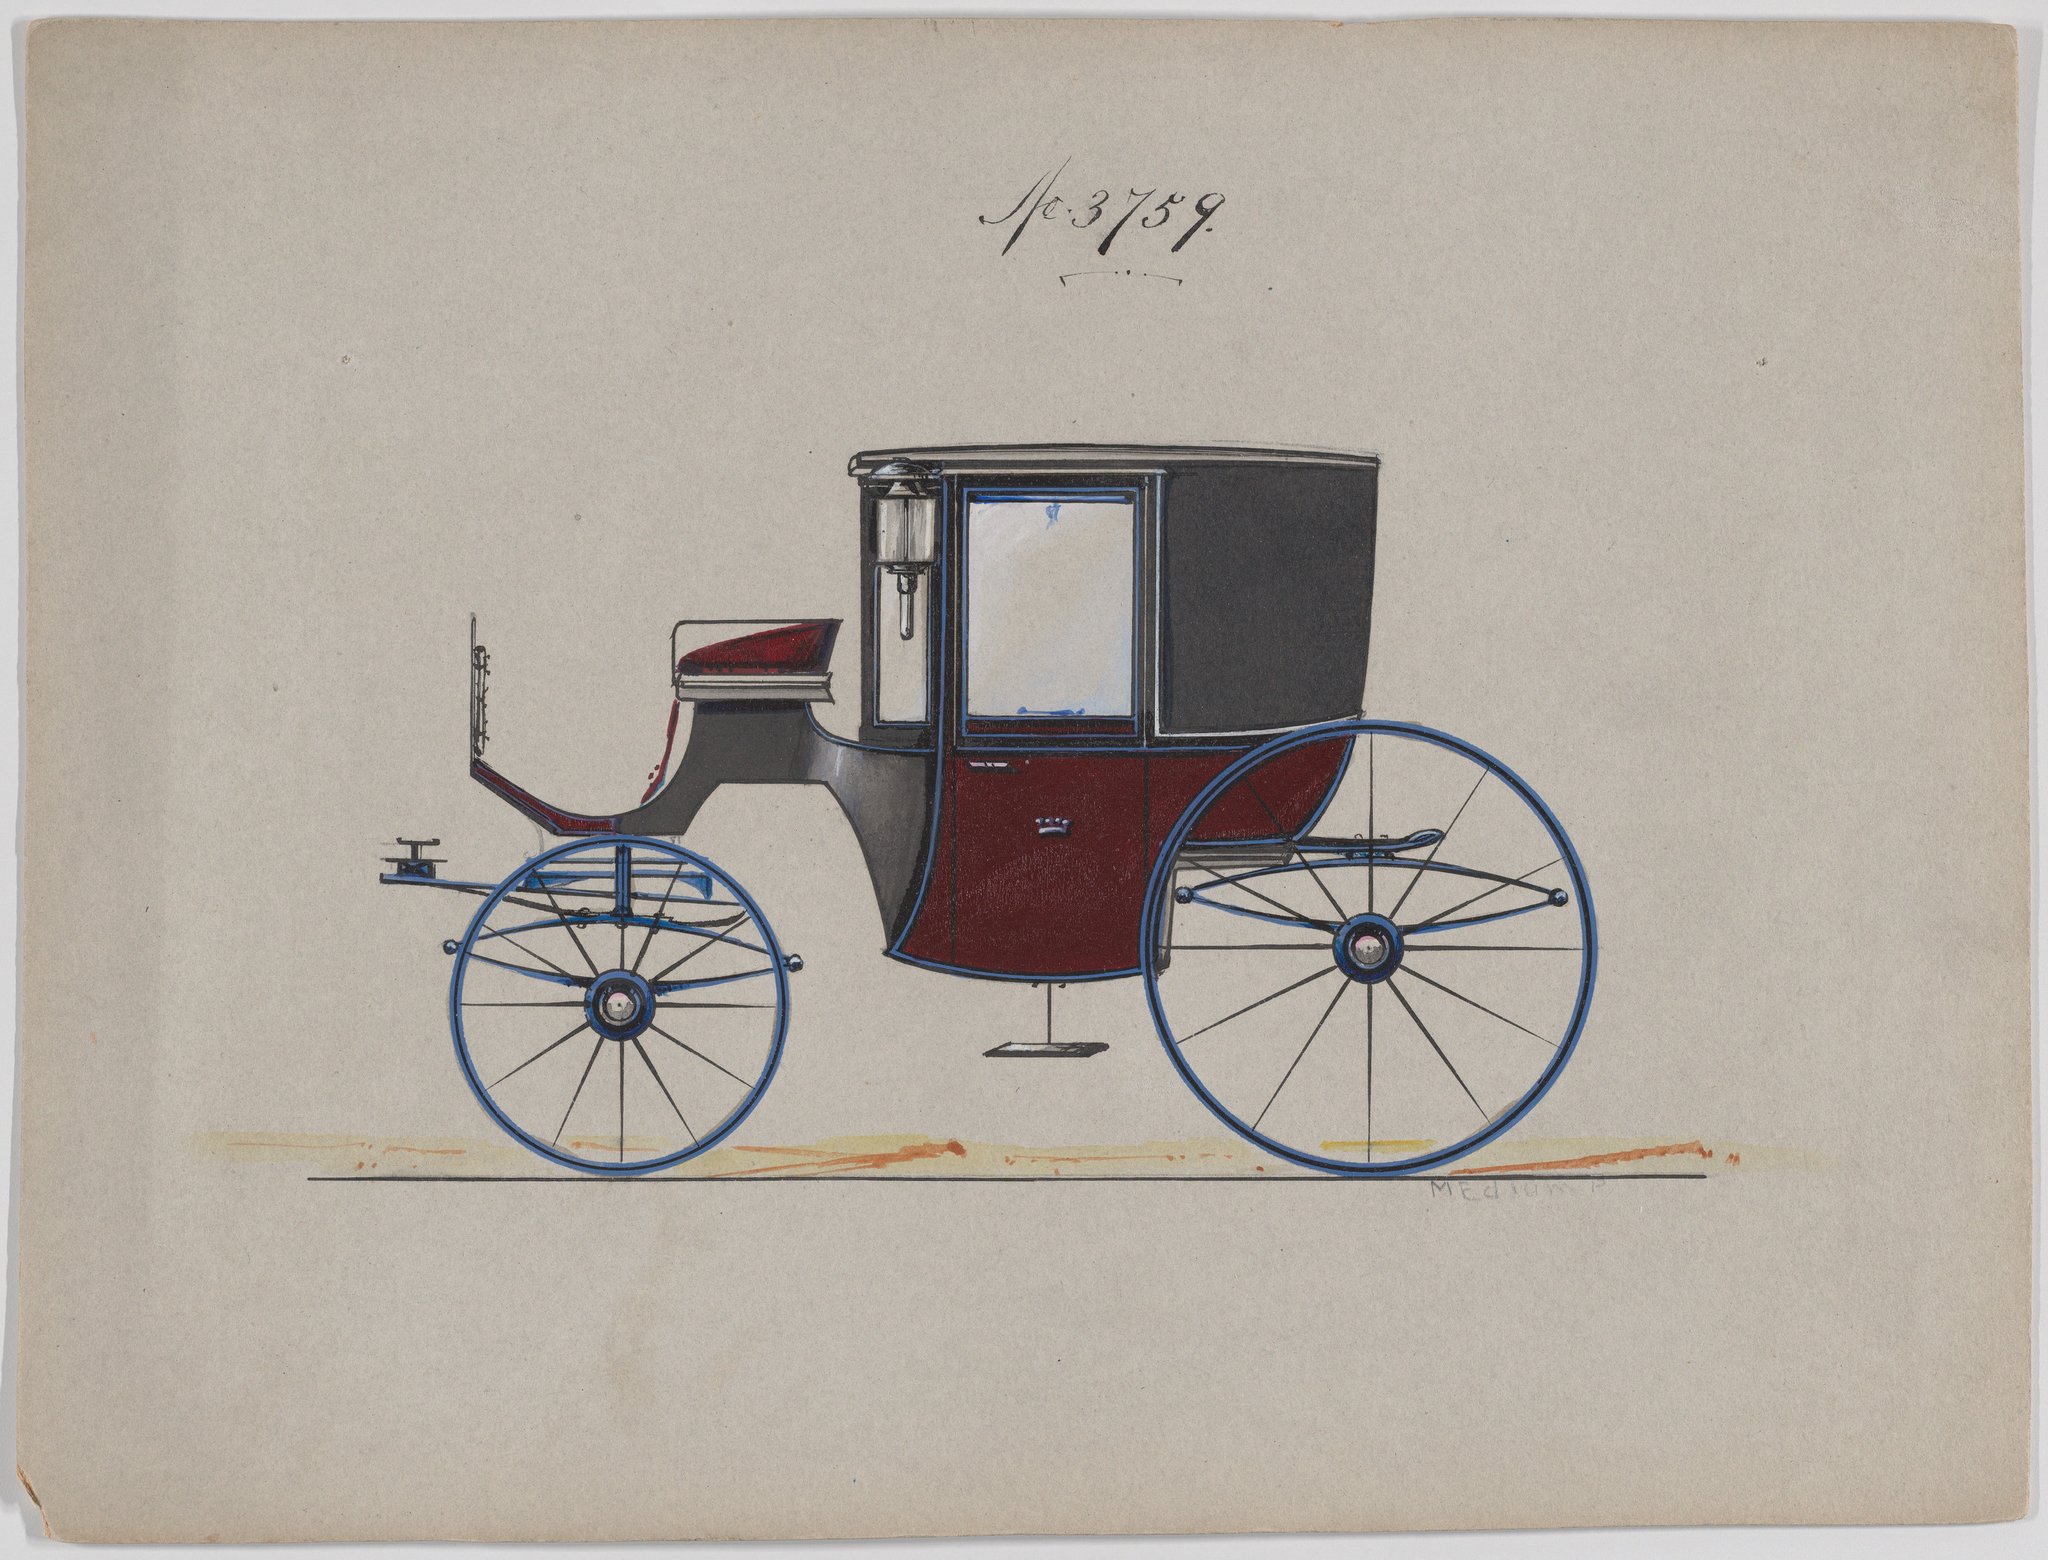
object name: drawing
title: Design for Coupé, no. 3759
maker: brewster & co.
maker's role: manufacturer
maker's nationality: american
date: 1882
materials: gouache, gum arabic, ink, watercolor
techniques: pen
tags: carriages